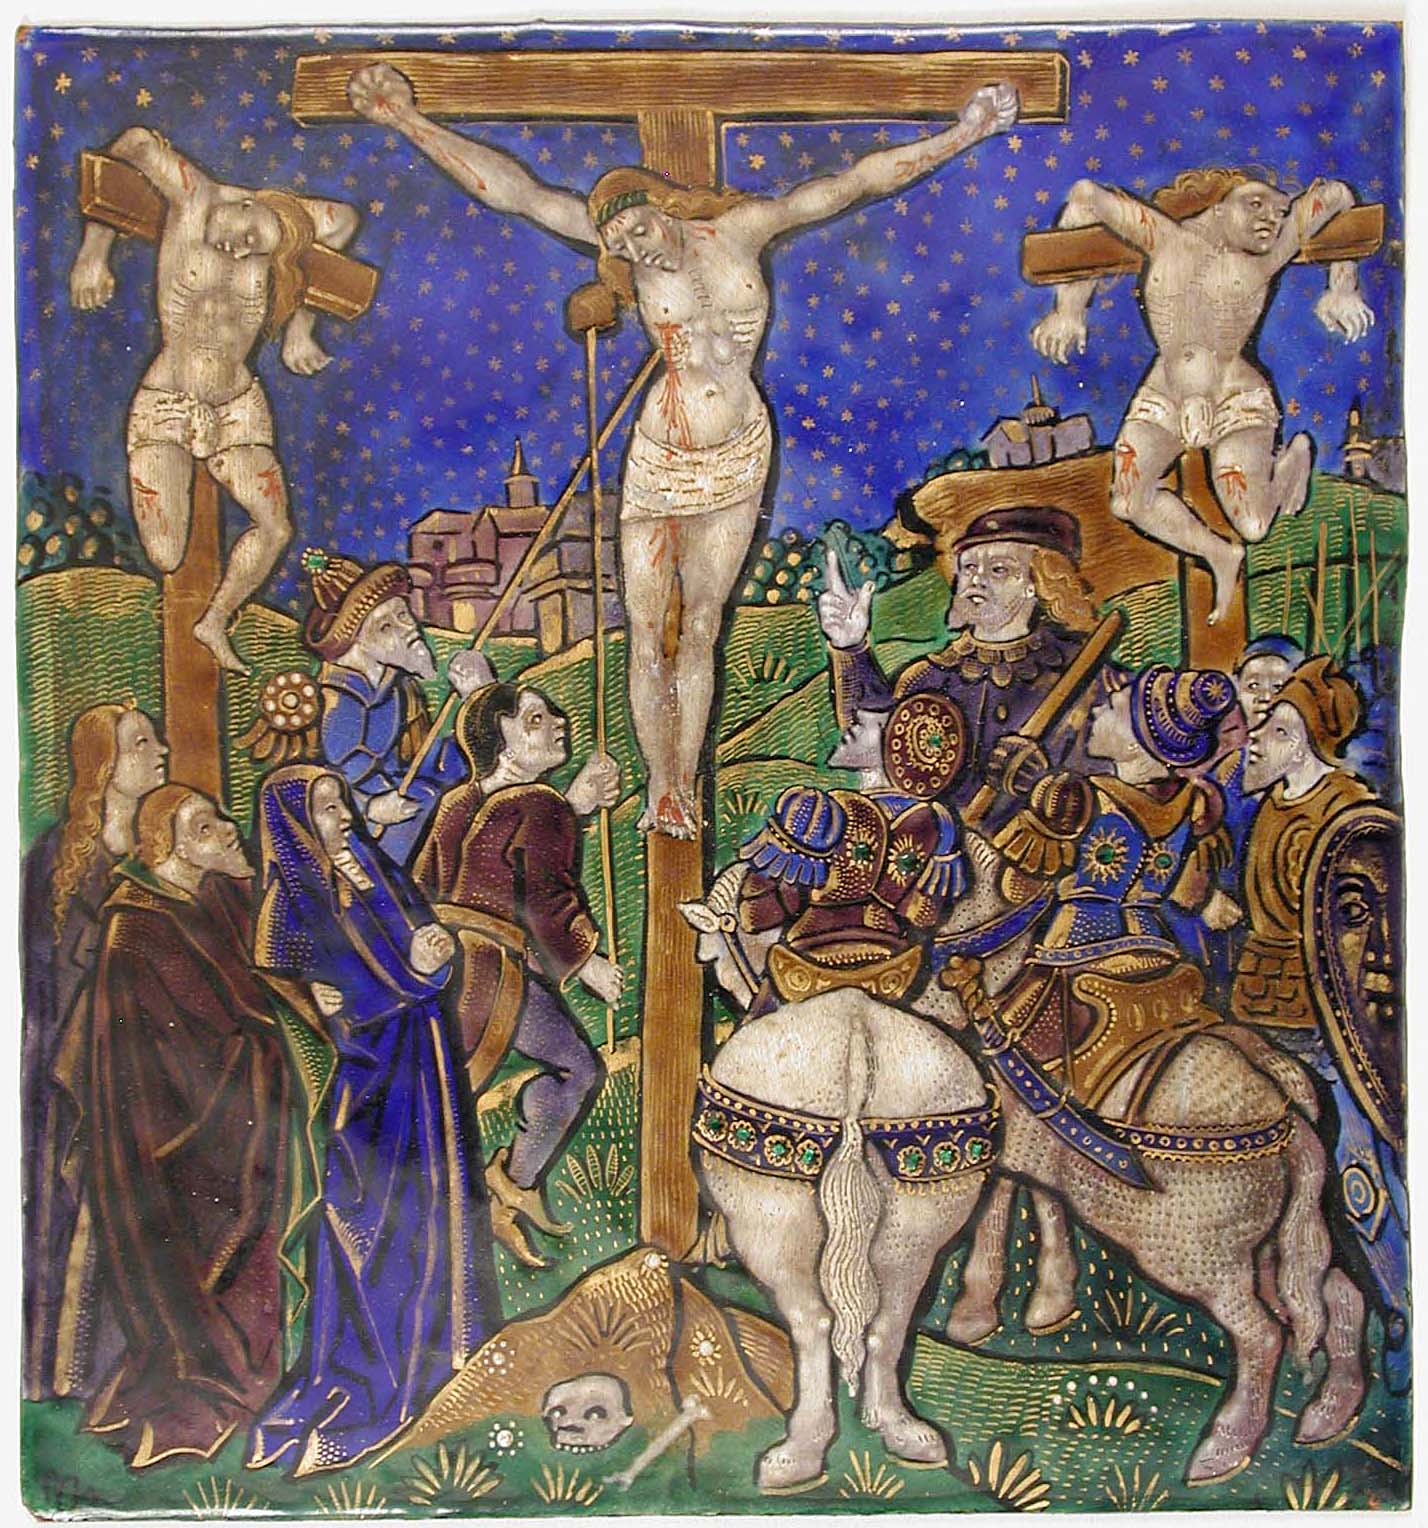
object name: triptych panel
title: Triptych Panel with the Crucifixion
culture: french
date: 1501-1533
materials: copper, enamel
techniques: painting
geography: france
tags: men,women,horses,christ